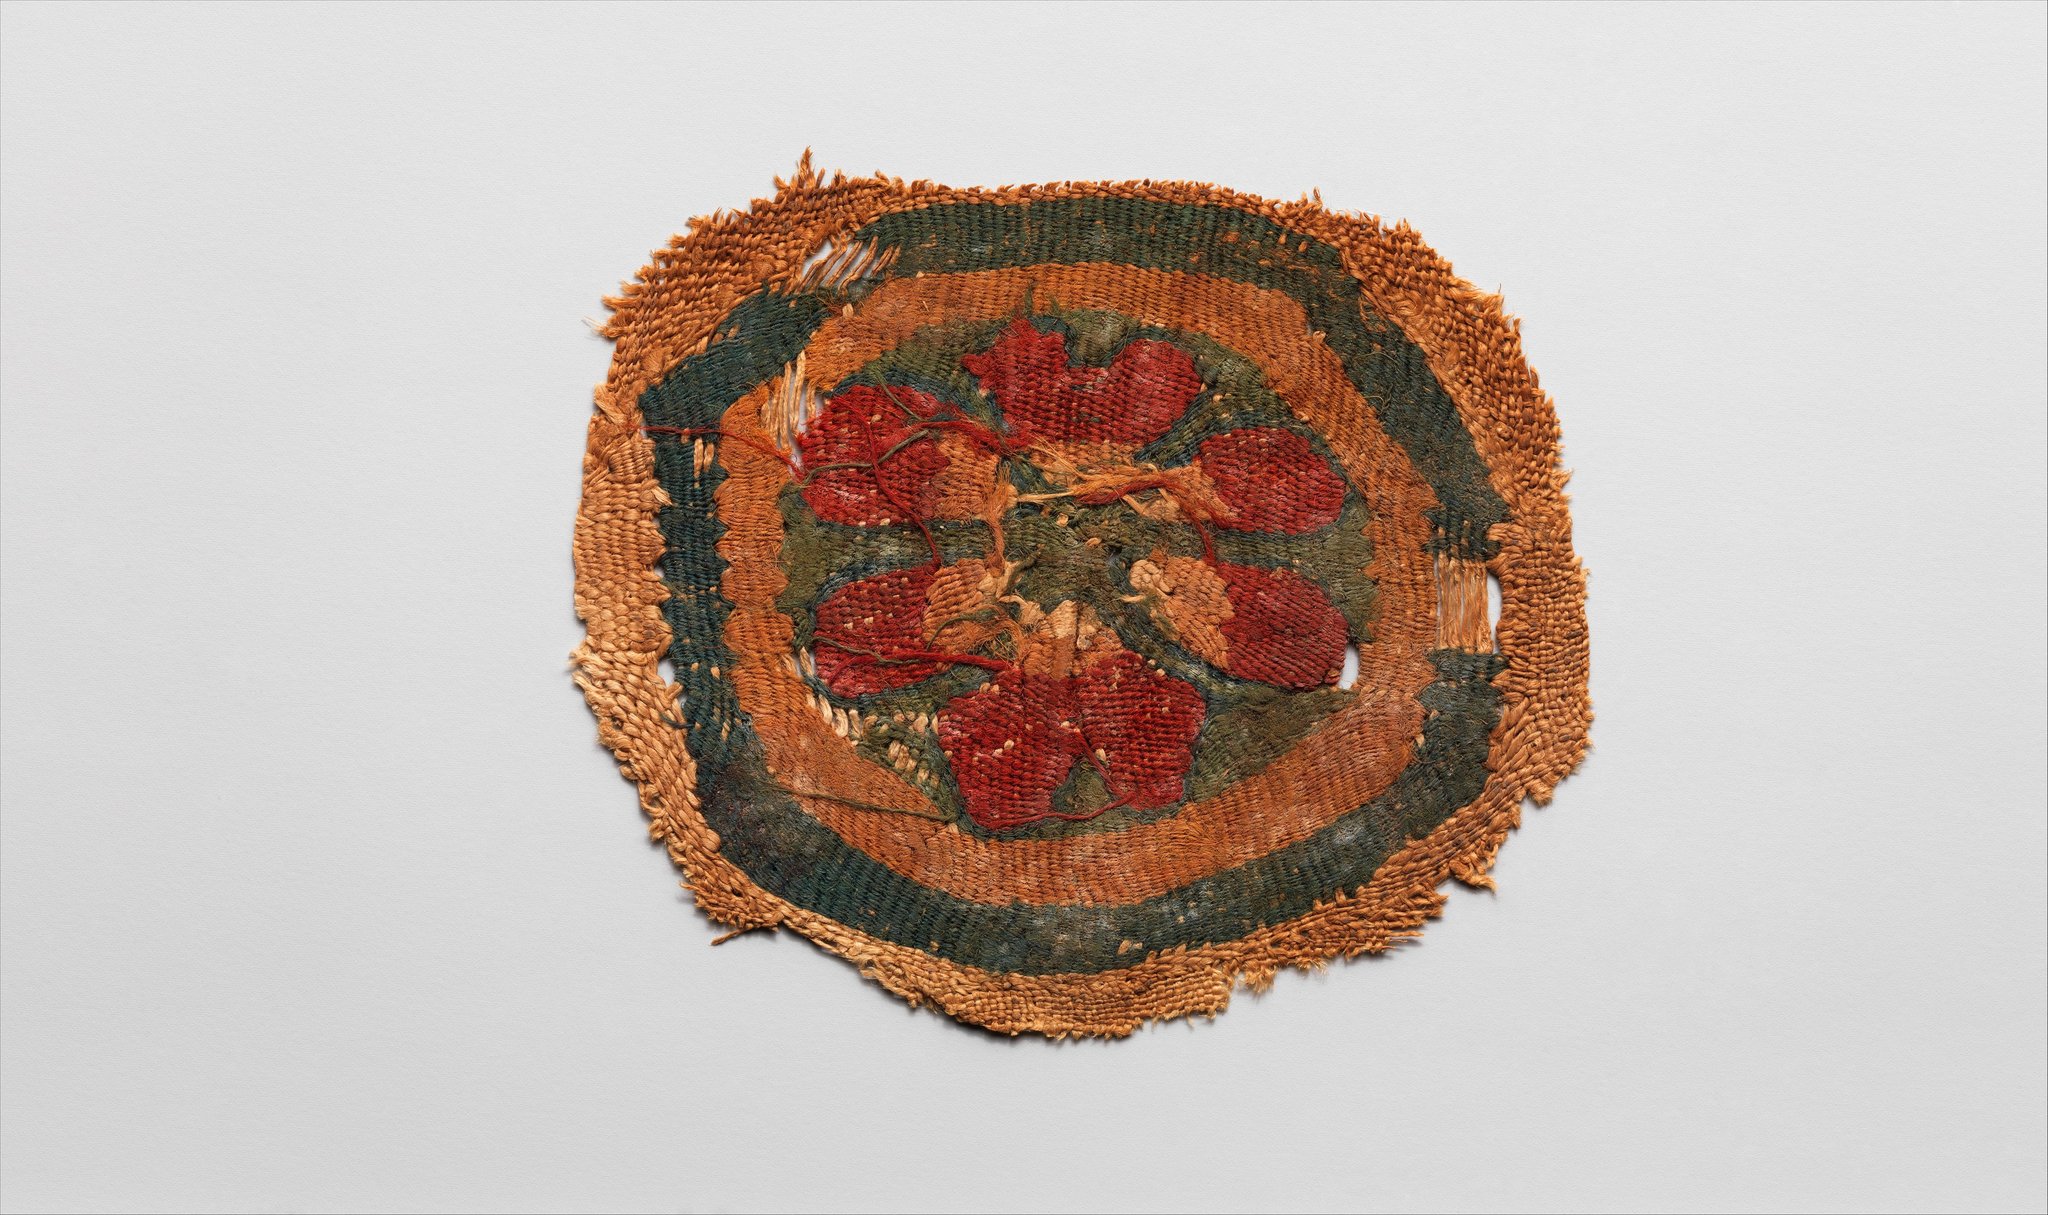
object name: textile fragment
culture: coptic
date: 501-600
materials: linen, wool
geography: egypt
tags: flowers